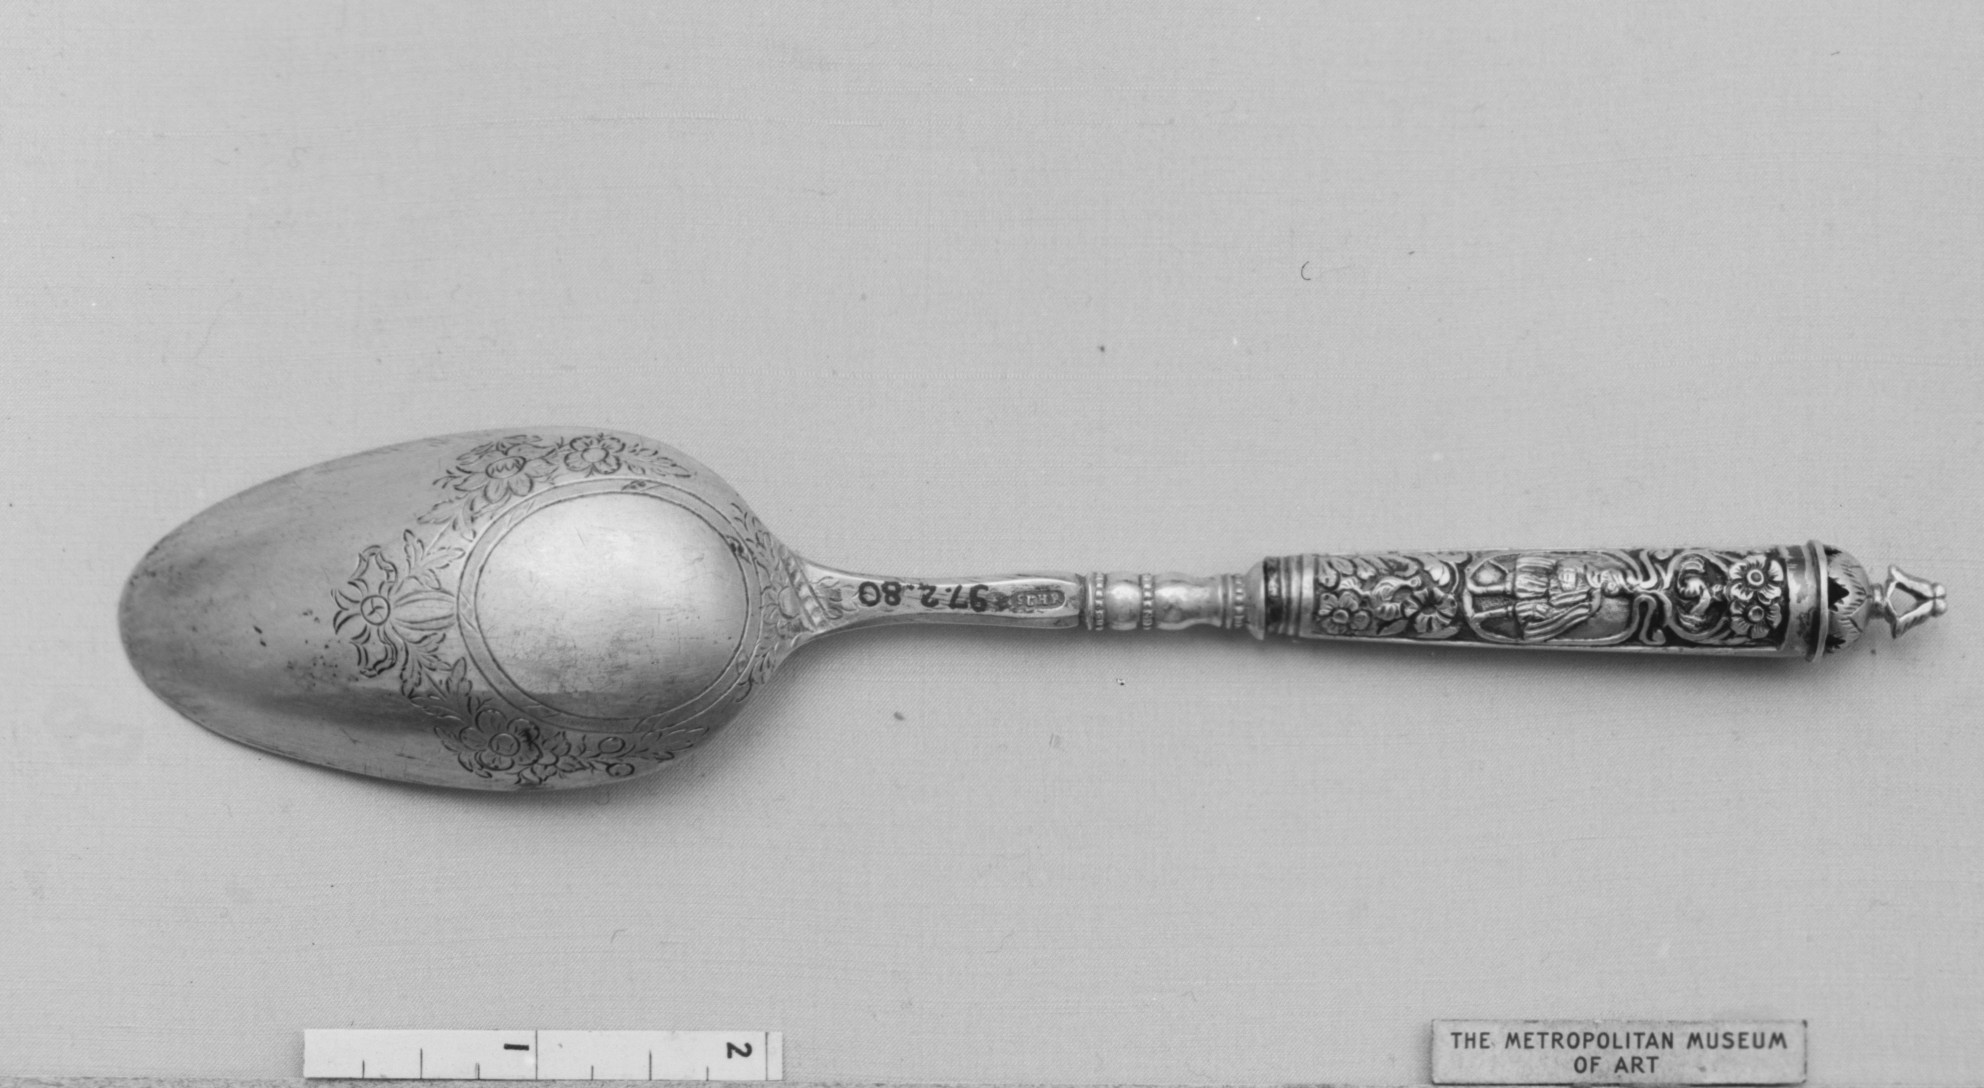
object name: spoon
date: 1701-1733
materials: gilt, silver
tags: men,flowers